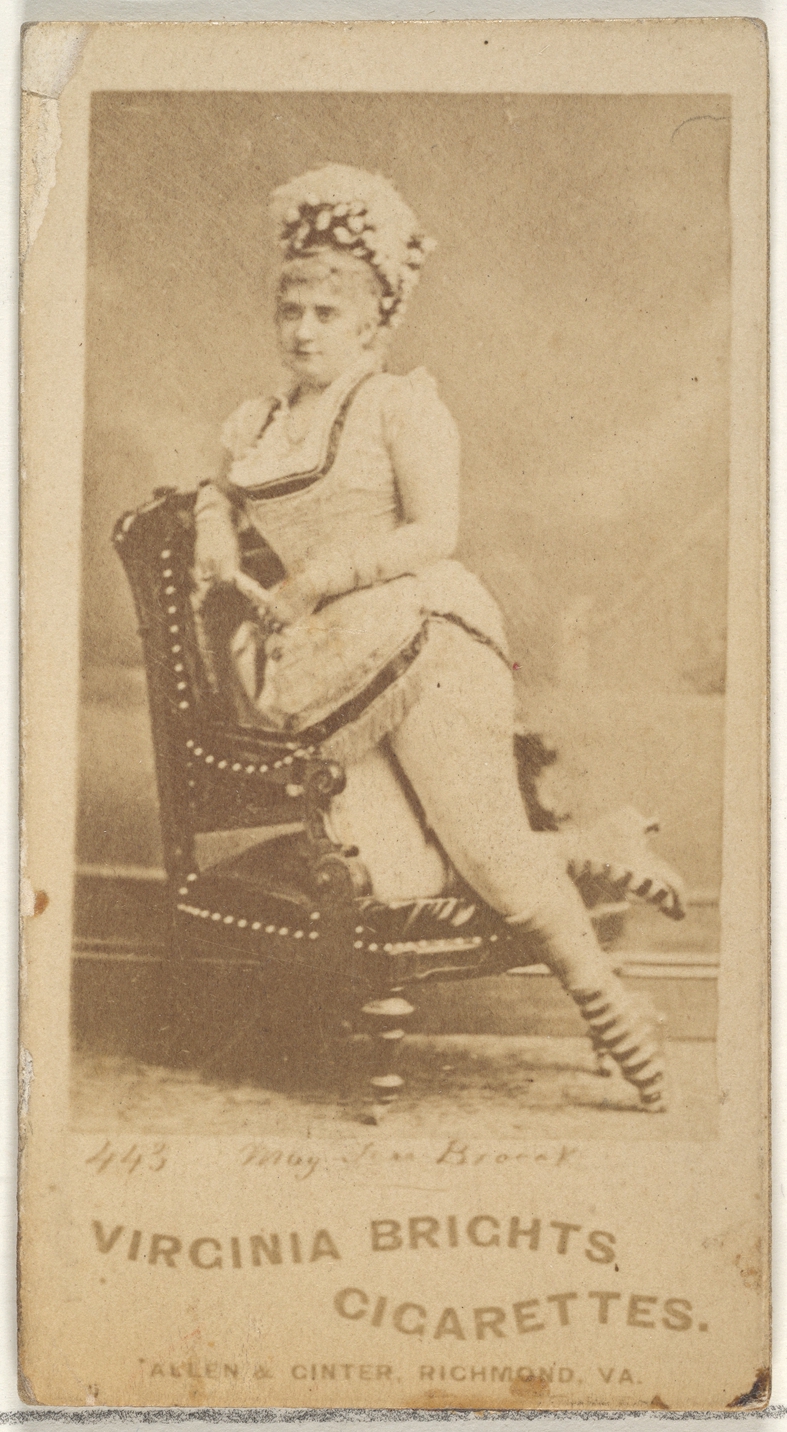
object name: photograph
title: Card 443, from the Actors and Actresses series (N45, Type 1) for Virginia Brights Cigarettes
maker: allen & ginter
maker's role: publisher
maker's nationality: american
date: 1888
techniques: albumen silver print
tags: portraits,women,actresses